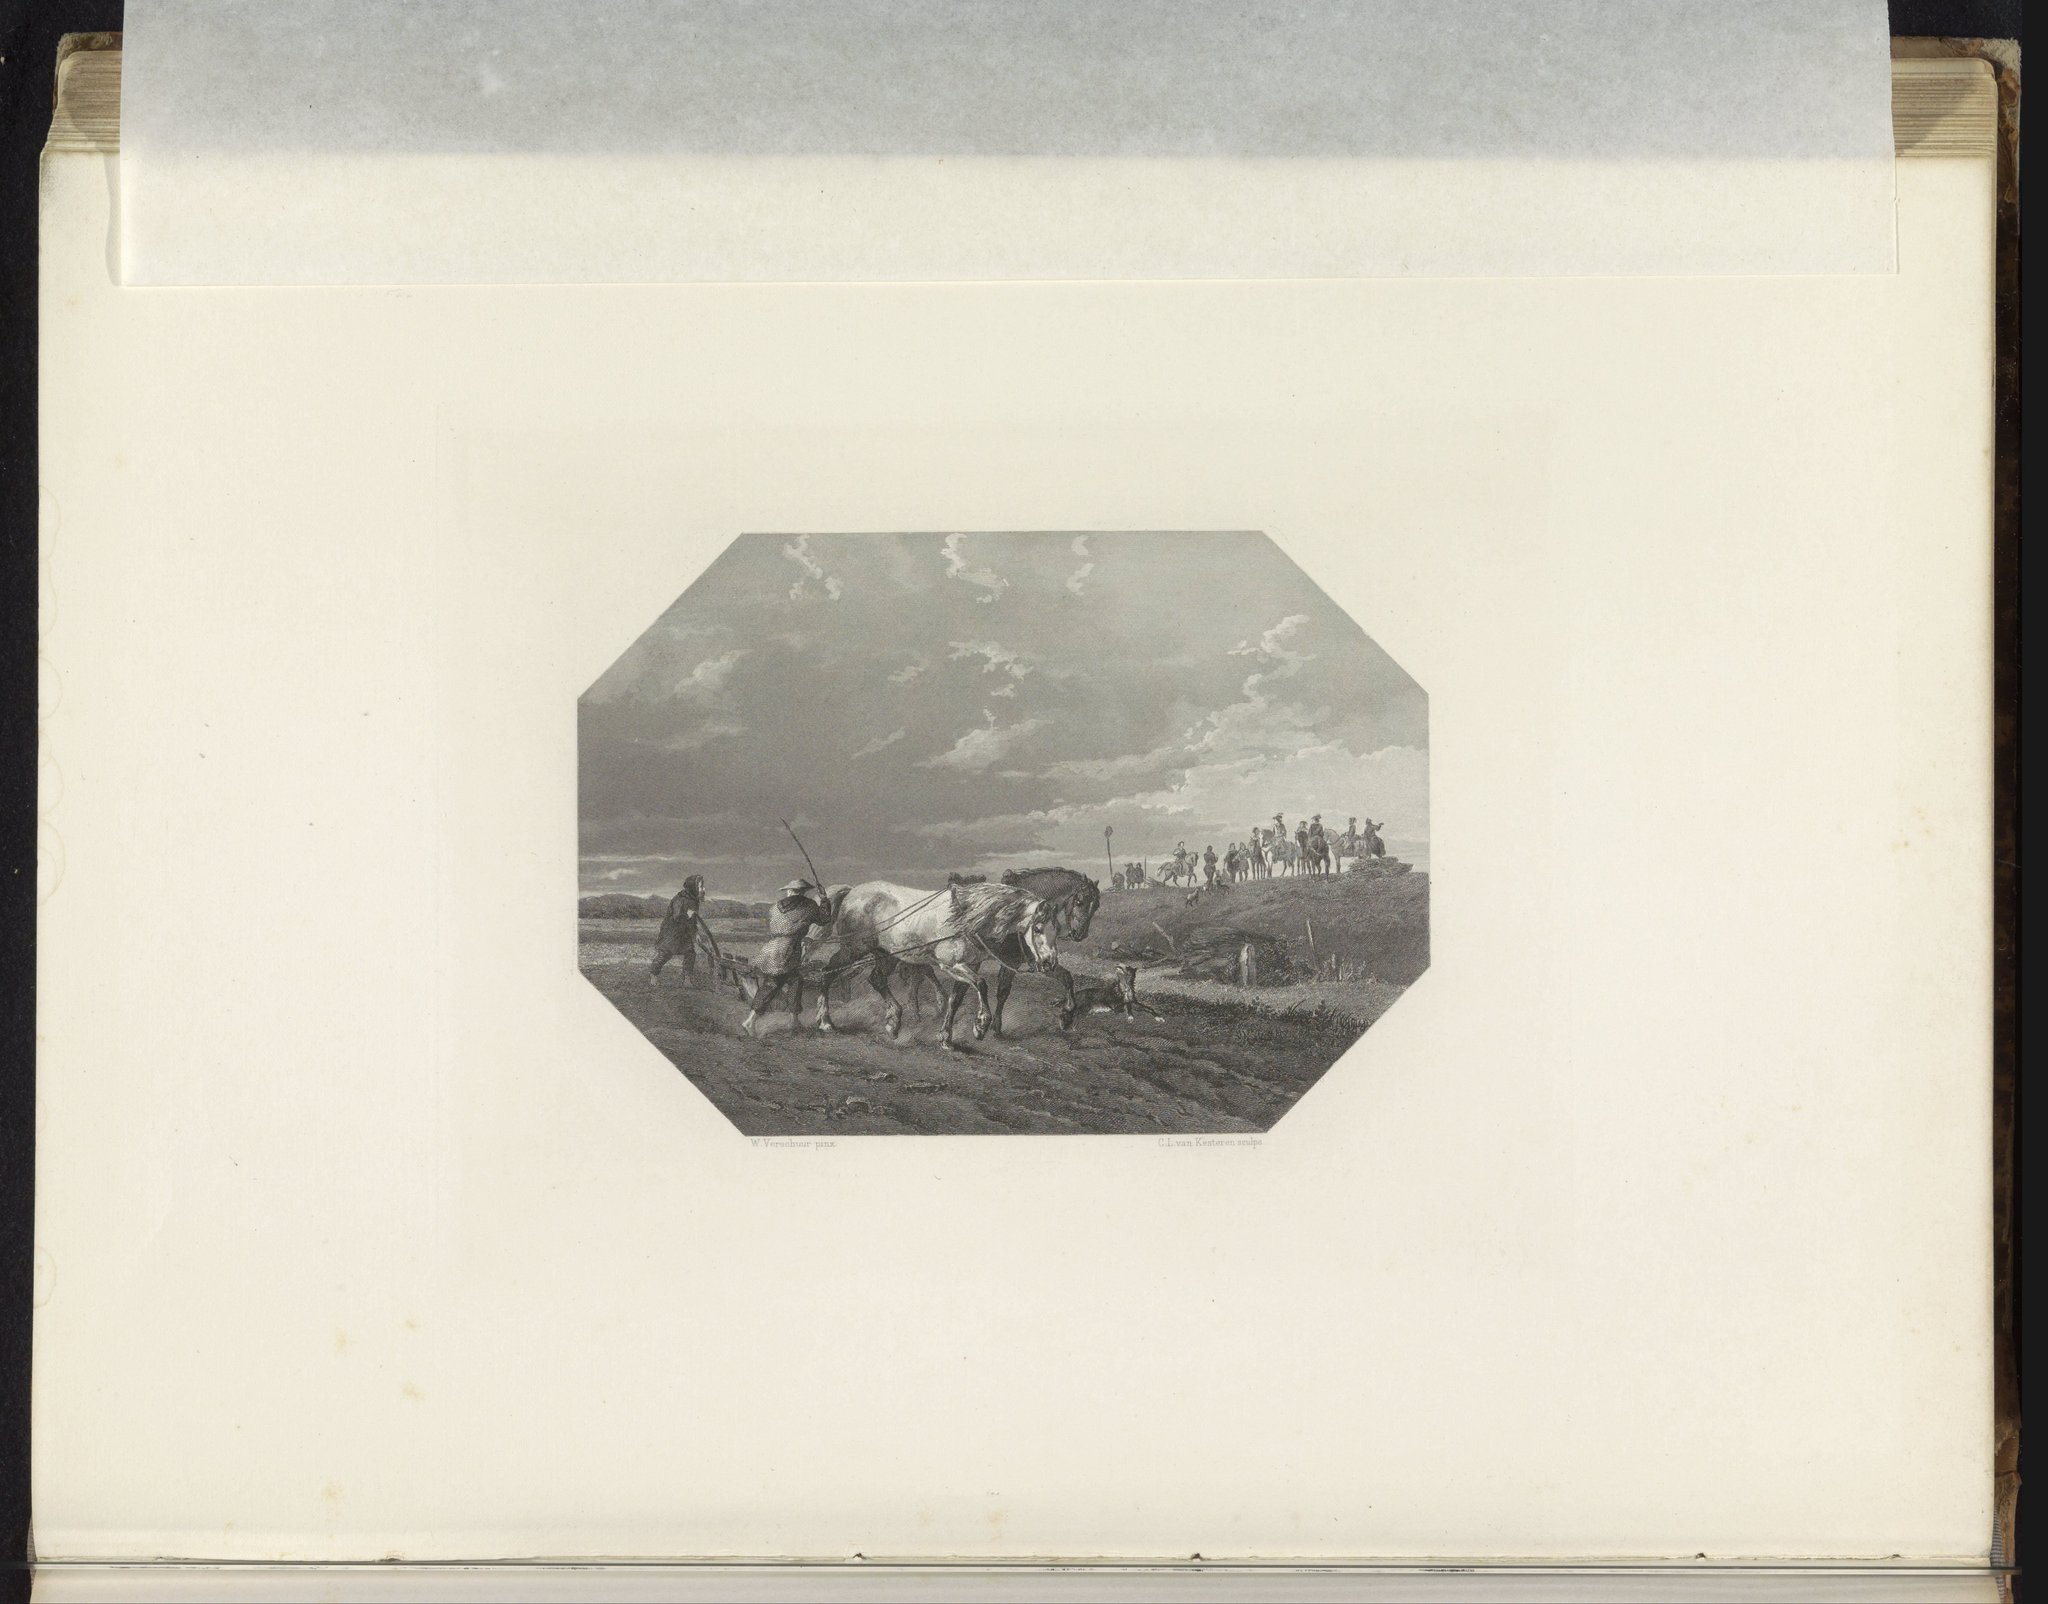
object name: history print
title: Eerste dijkschouw in Drechterland, 1288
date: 1865-1870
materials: paper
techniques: engraving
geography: netherlands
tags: drechterland, nederland tijdens de late middeleeuwen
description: Eerste dijkschouw in Drechterland, 1288. Een groepje personen op een dijk. Op de voorgrond een ploegende boer. Onderdeel van de groep staalgravures naar de schilderijen van de Historische Galerij der Maatschappij Arti et Amicitiae.